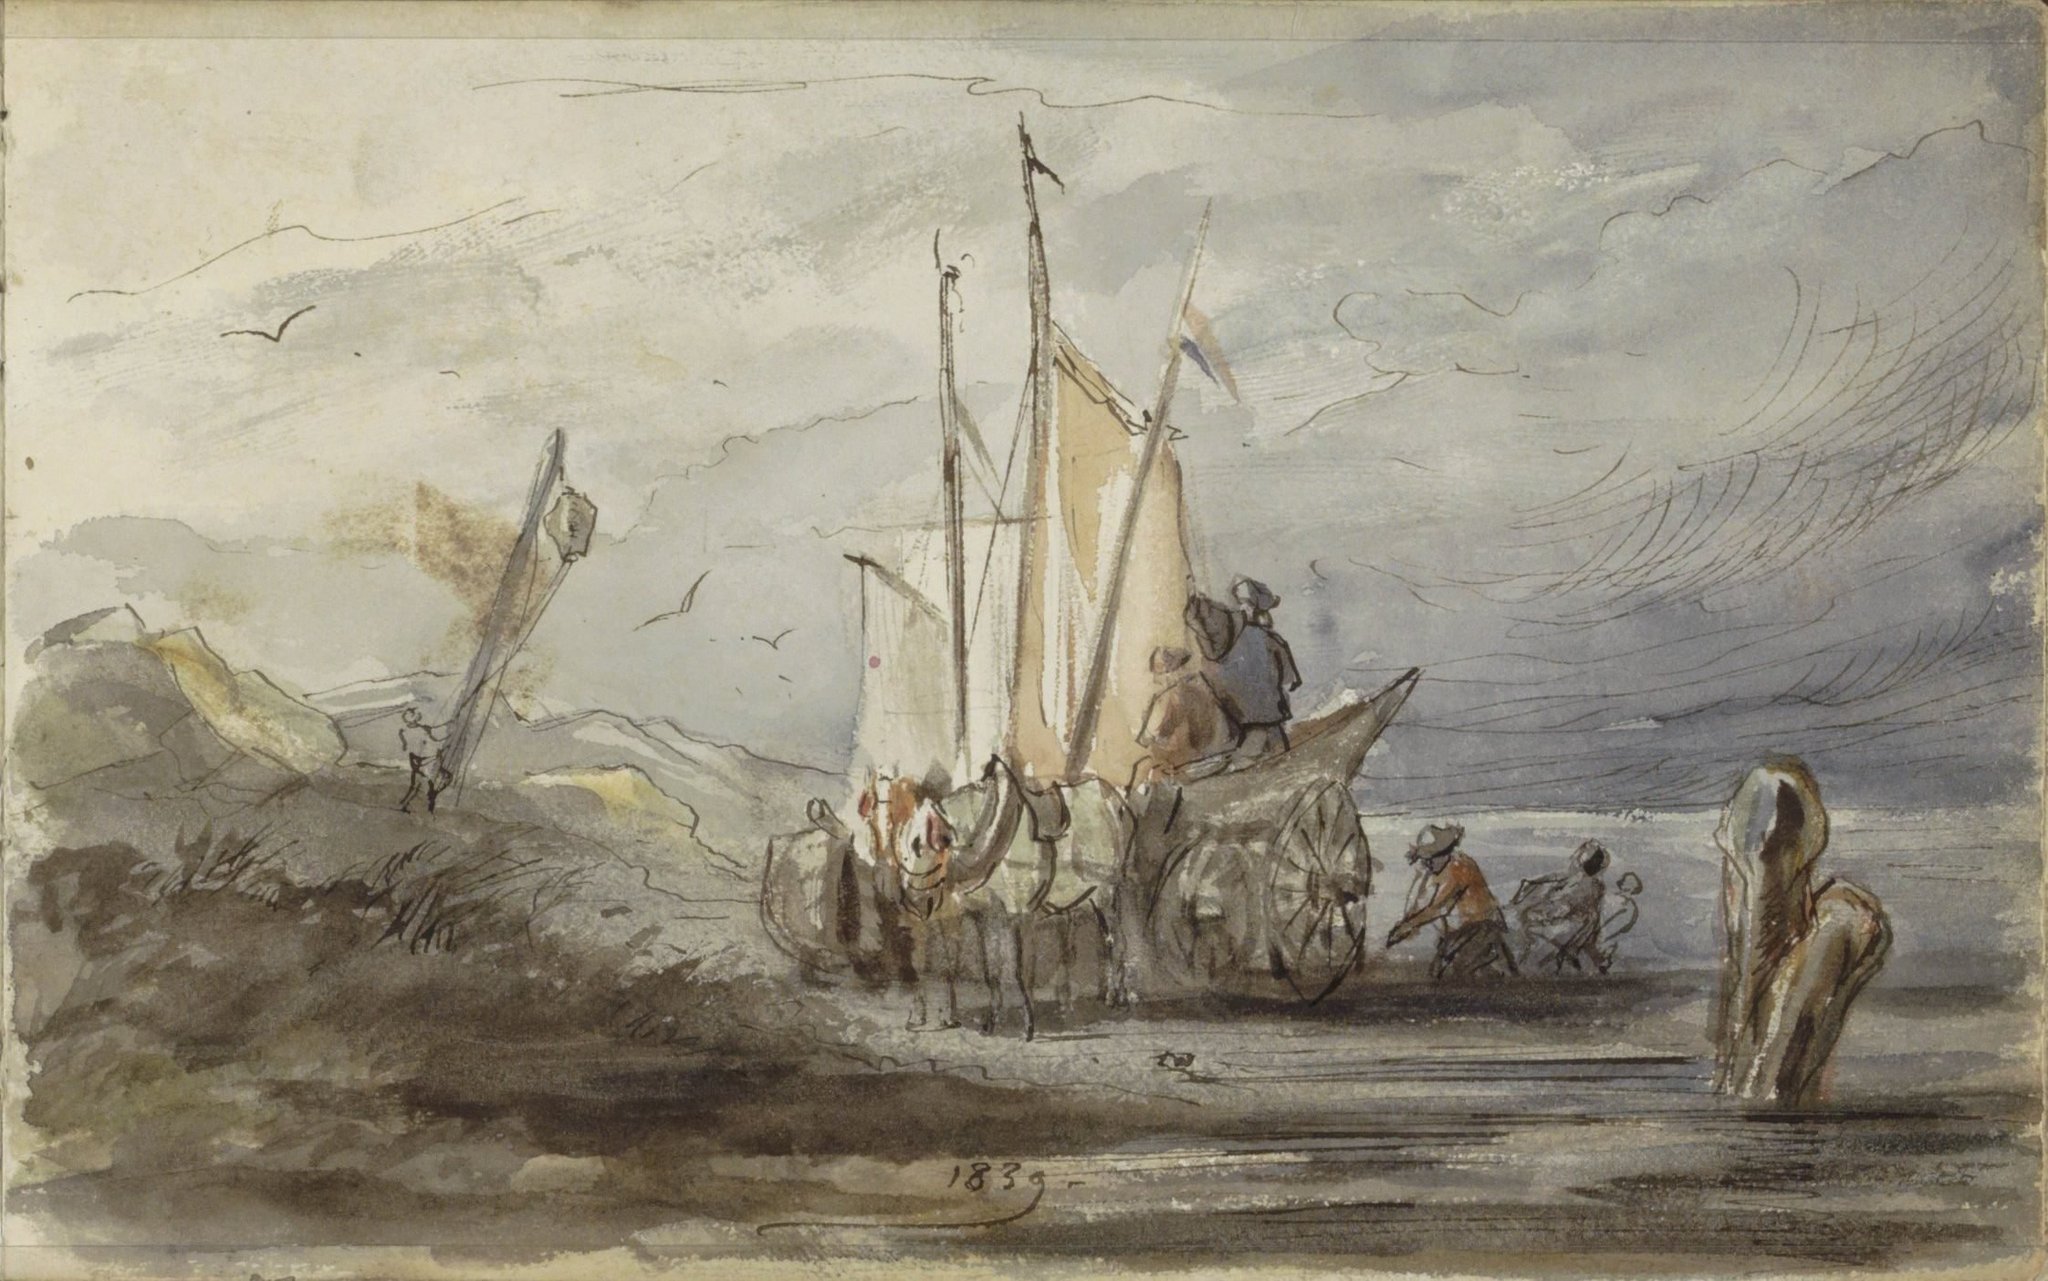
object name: watercolor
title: Paard en wagen aan een oever bij een zeilschip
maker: johannes tavenraat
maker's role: draughtsman, painter, print maker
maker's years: 1809-1881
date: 1839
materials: paper, watercolor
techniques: brush, pen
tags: animal traction, animal-drawn vehicle (carriage etc.), dune coast, sailing-ship, sailing-boat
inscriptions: date: ‘1839 -’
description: Met enkele figuren rondom de boot en op de kar. Blad 2 recto uit een schetsboek met 37 bladen.